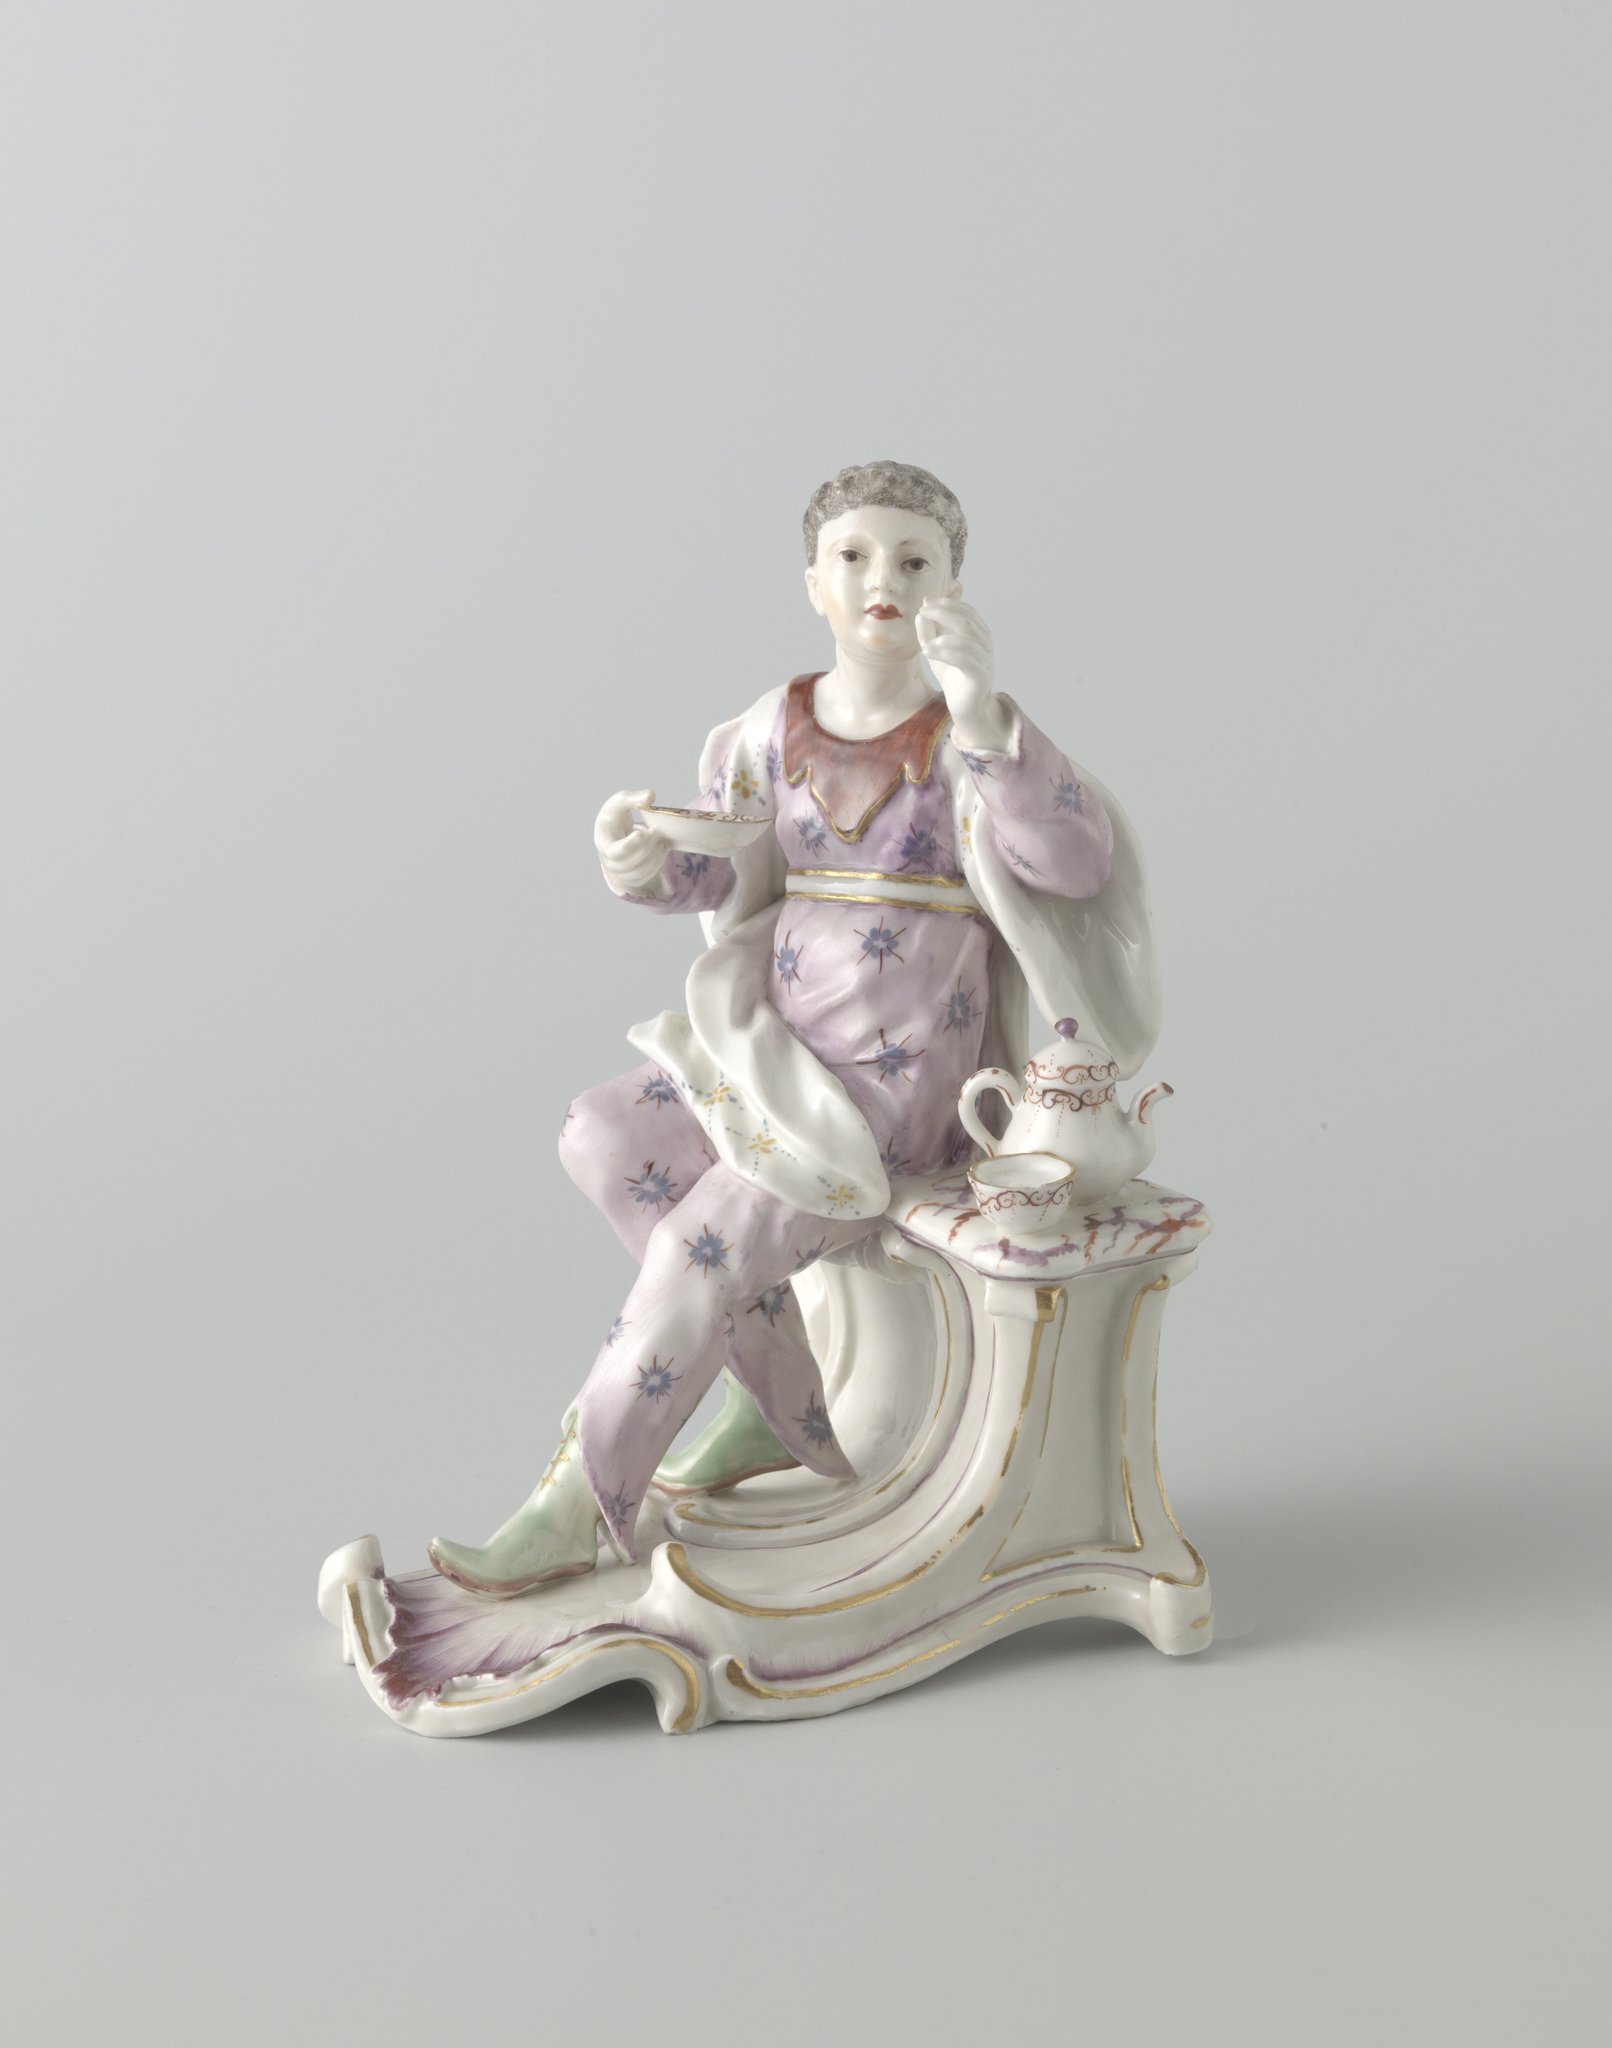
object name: figure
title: Figure of a seated womand with tea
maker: johann friedrich lück (der jüngere)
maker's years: 1727-1797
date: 1755-1762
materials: glaze, gold, paint, porcelain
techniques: firing, forming, gilding, vitrification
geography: frankenthal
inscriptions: mark: ‘leeuw’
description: A Chinese woman. Porcelain. Frankenthal, c. 1755 - 1762, model by Johann Friedrich Lück. Given by the Committee for Photographic Sales.